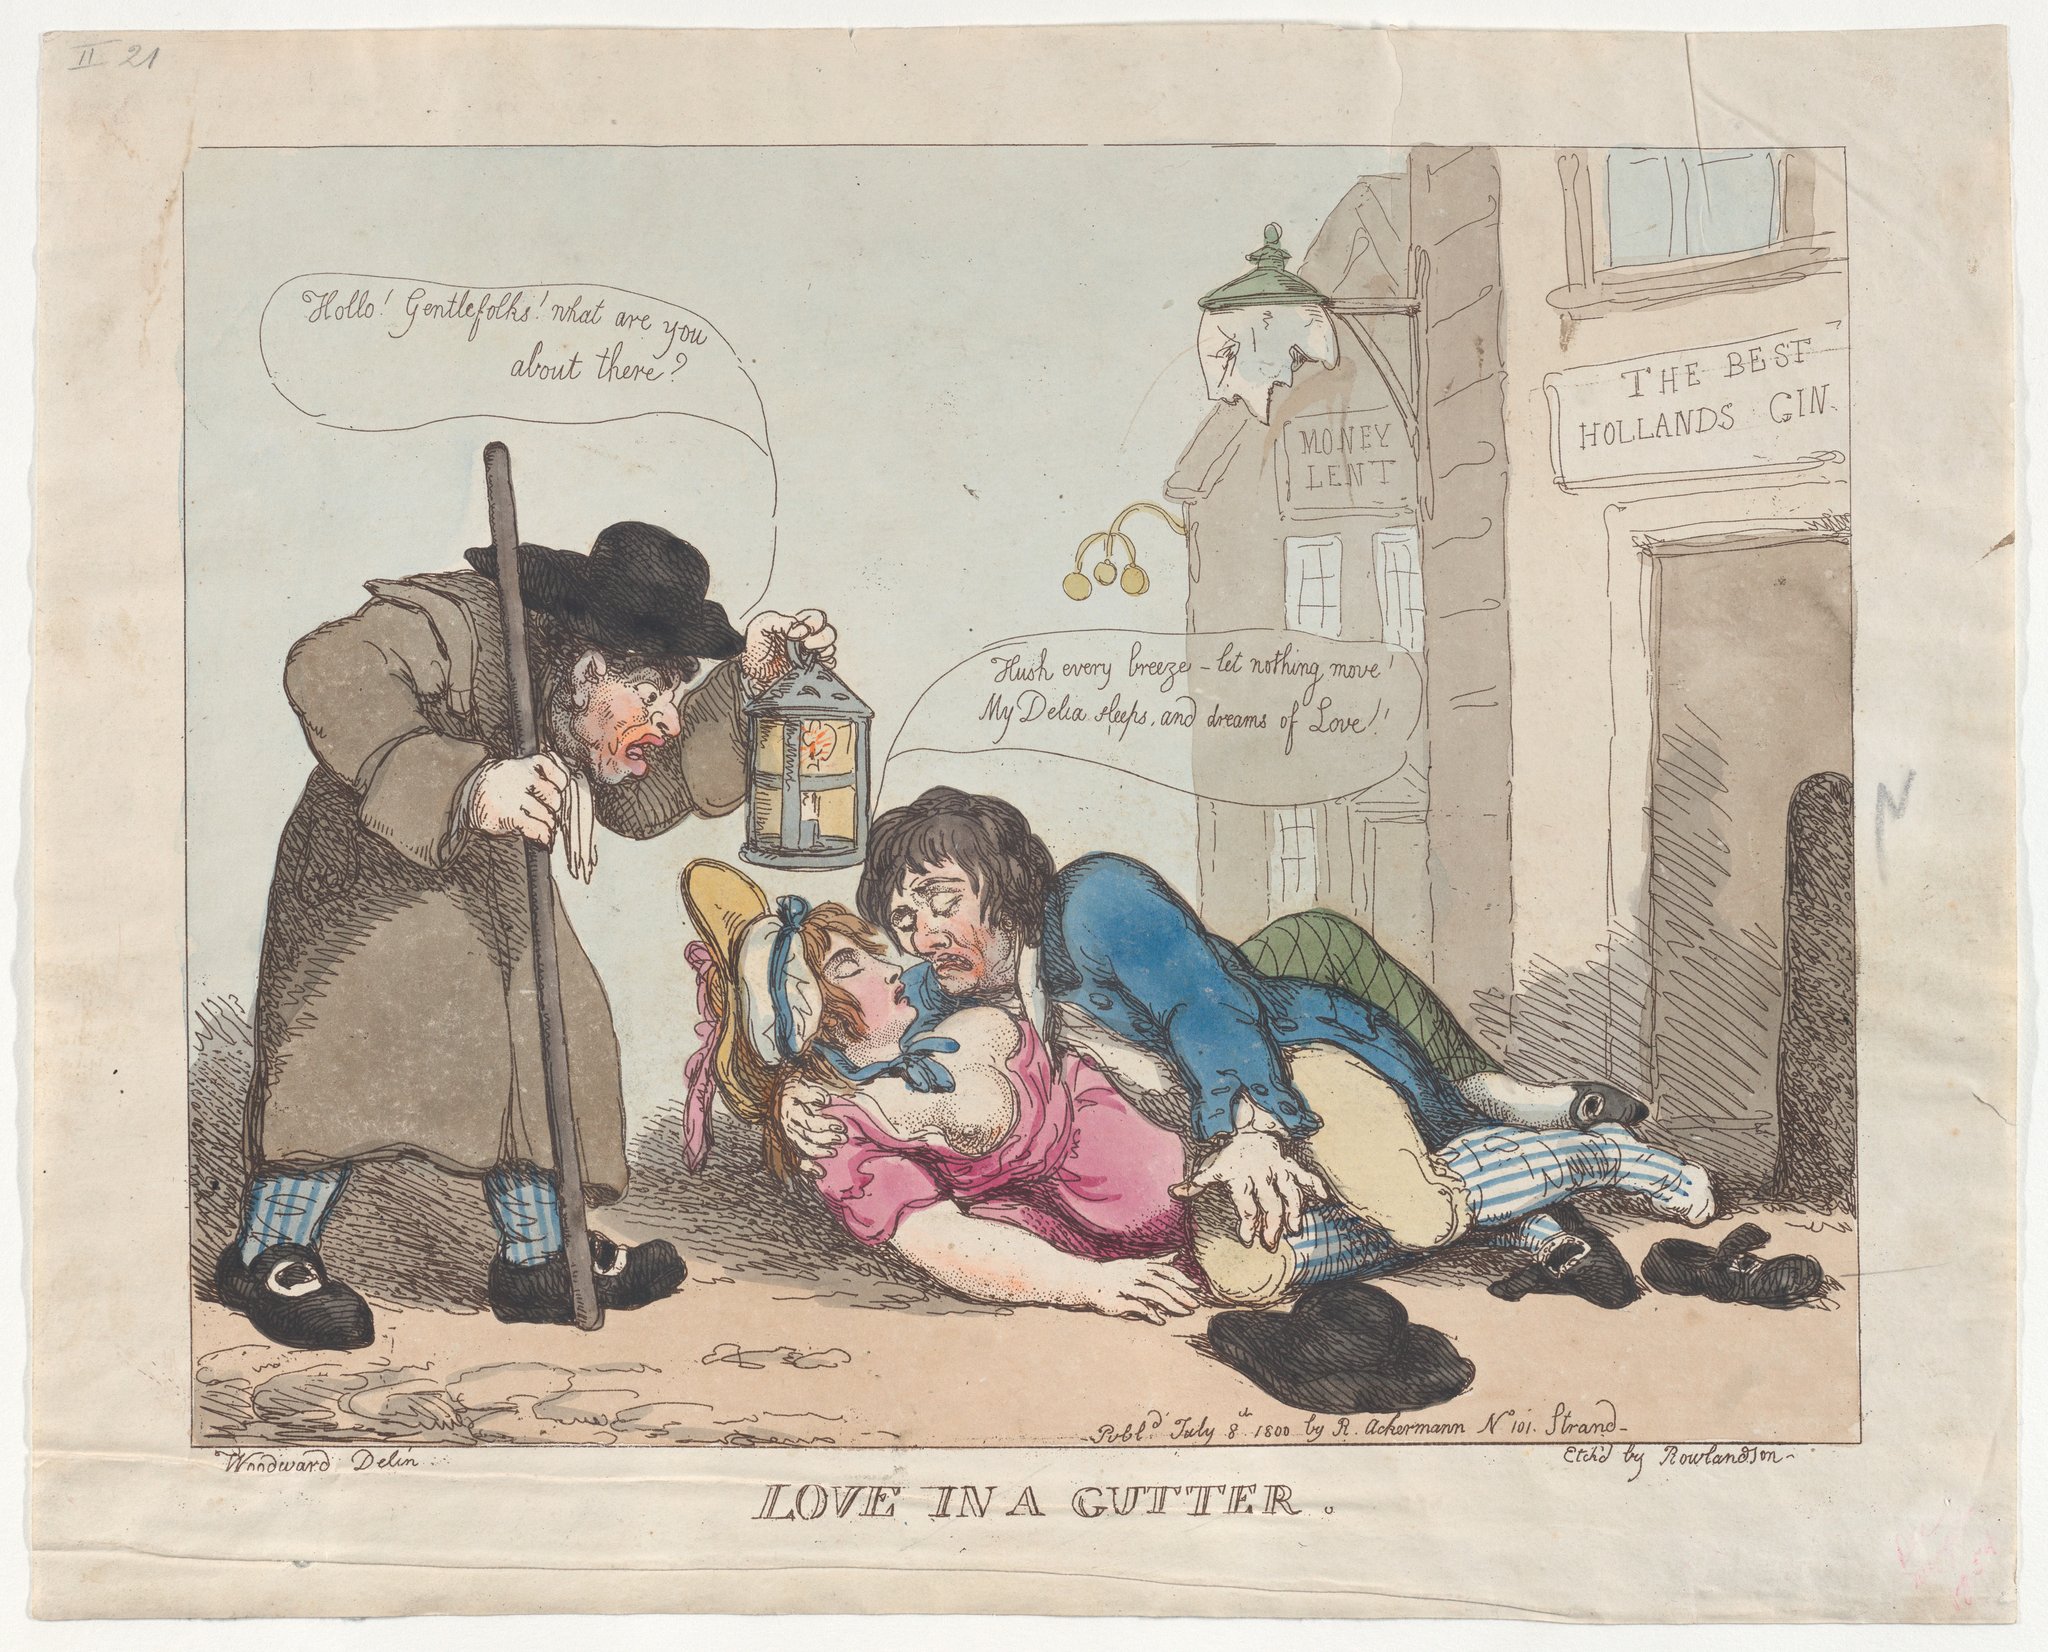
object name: print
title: Love in the Gutter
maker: thomas rowlandson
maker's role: artist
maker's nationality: british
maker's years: 1757-1827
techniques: etching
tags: satire,women,monkeys